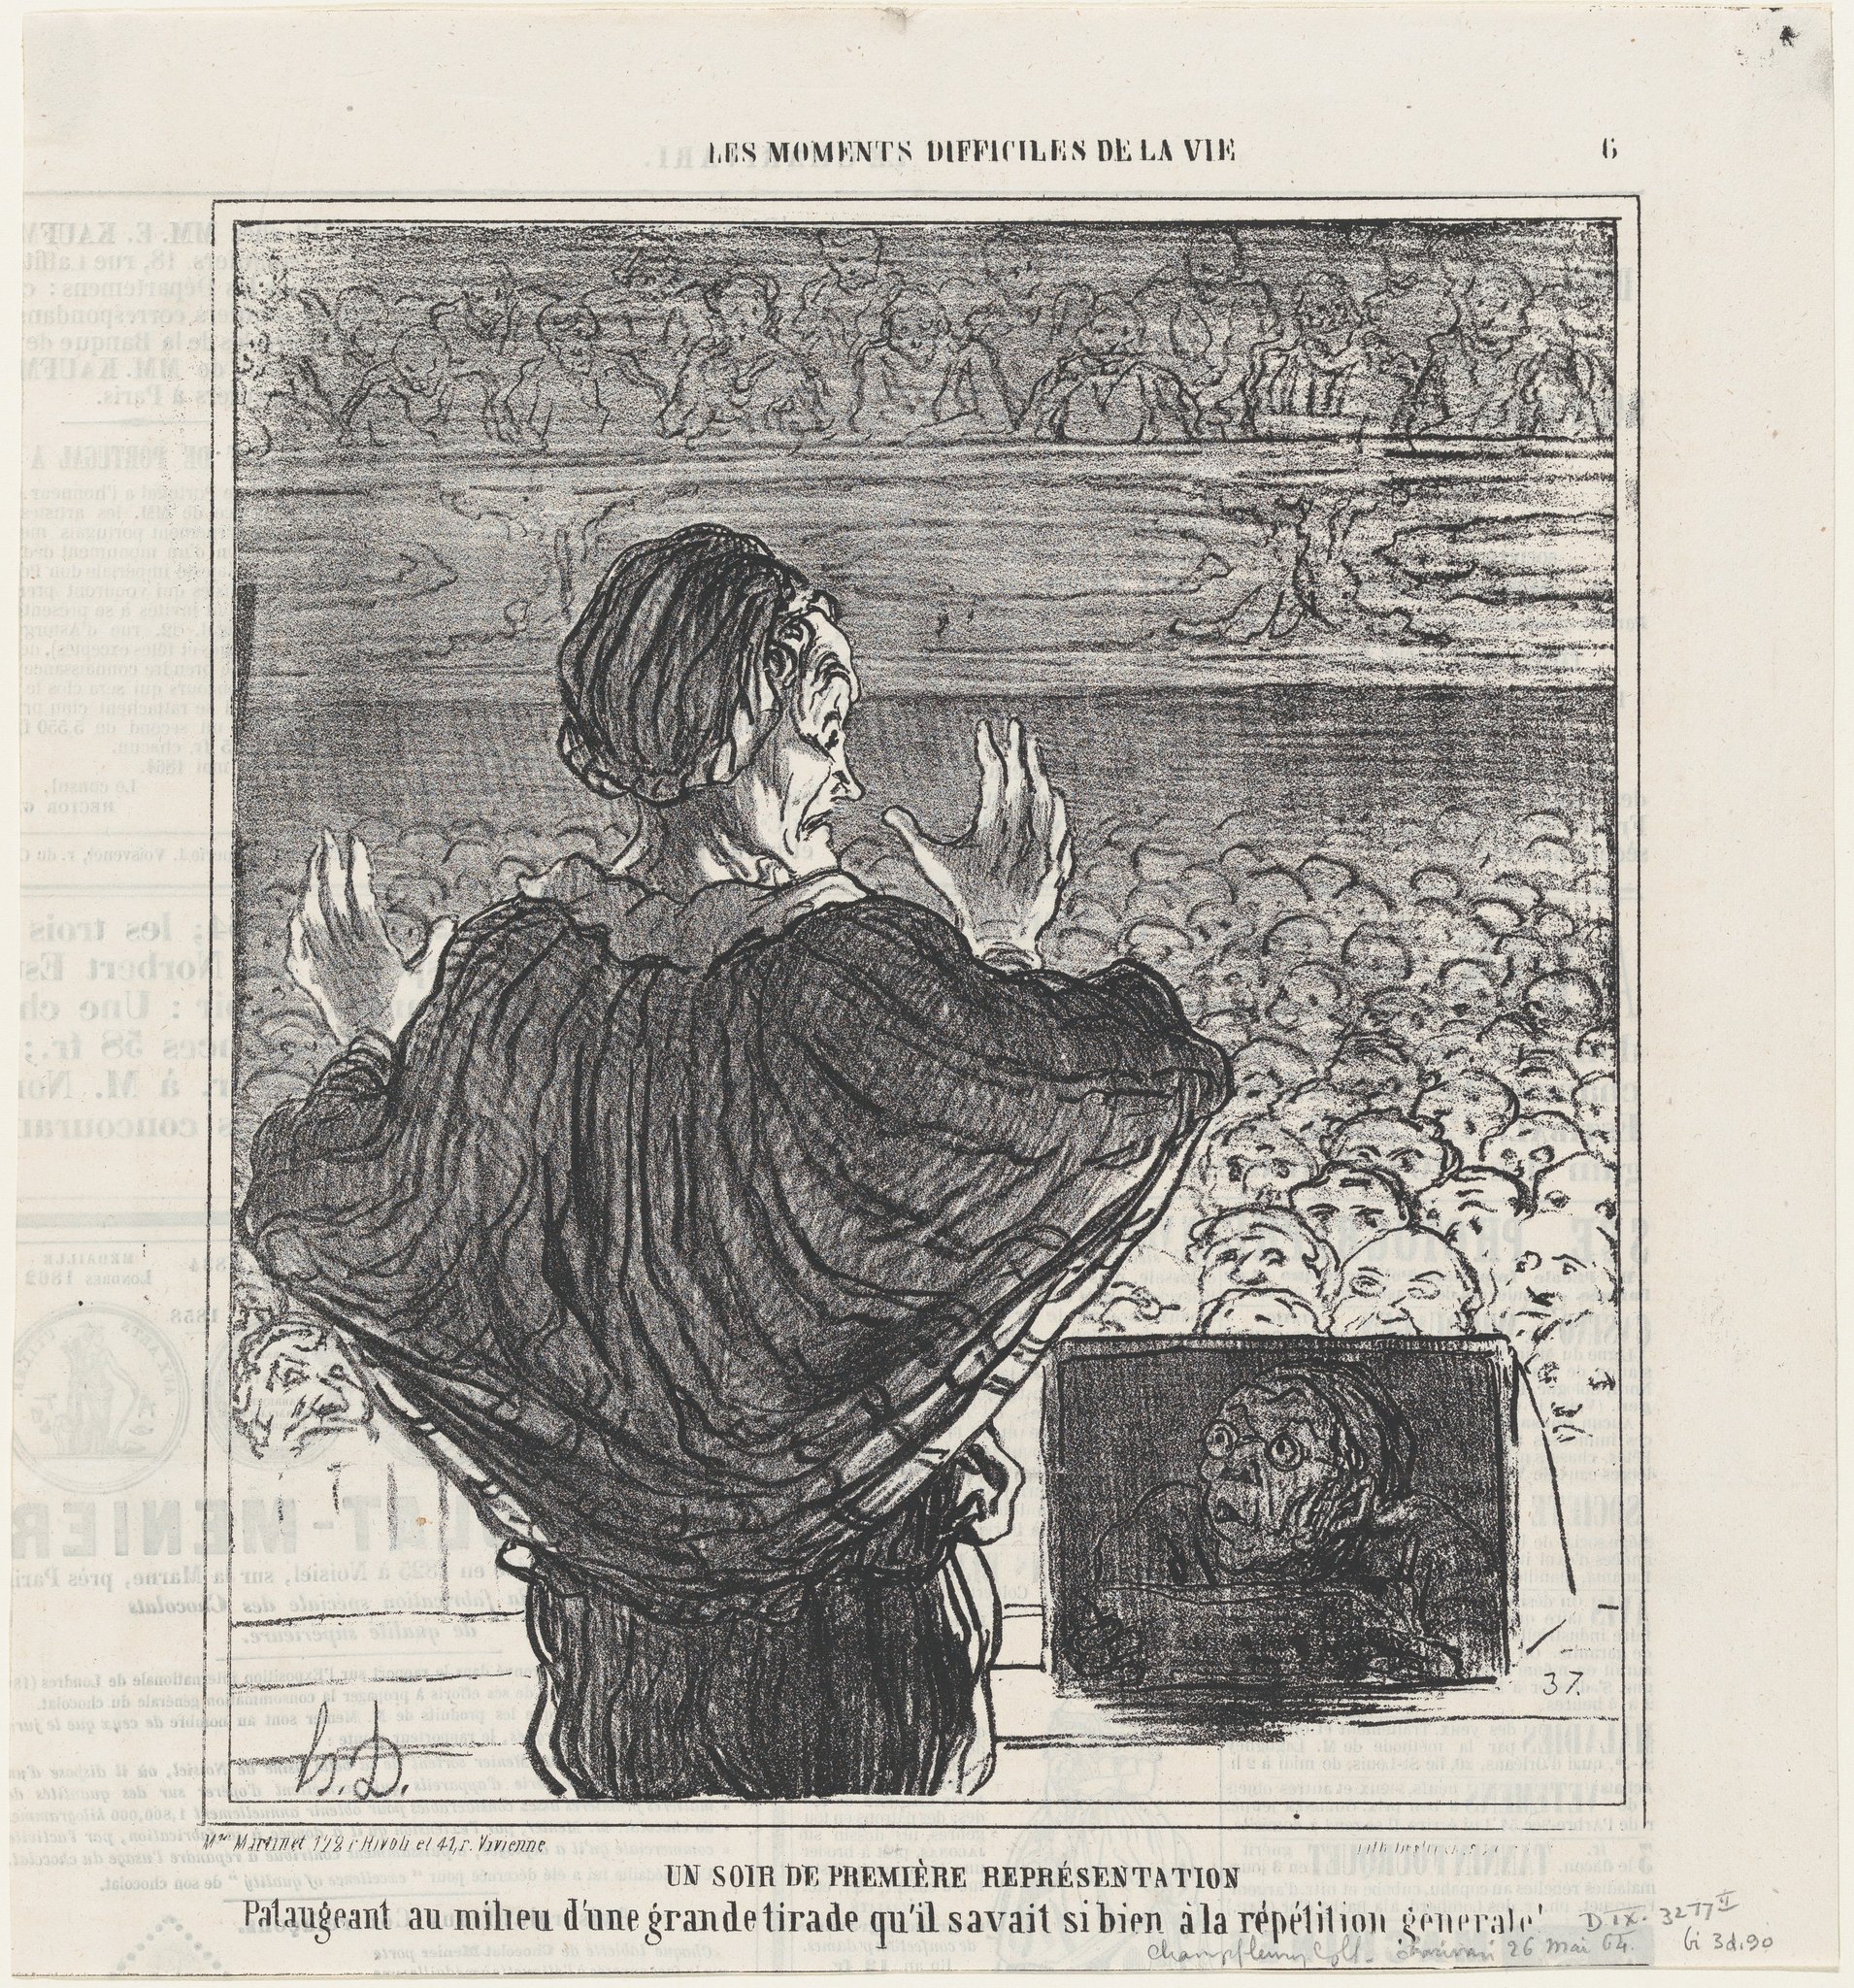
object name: print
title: Opening night, from 'The difficult moments of life,' published in Le Charivari, May 26, 1864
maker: honoré daumier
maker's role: artist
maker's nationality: french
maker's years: 1808-1879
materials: paper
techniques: lithograph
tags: satire,theatre,spectators